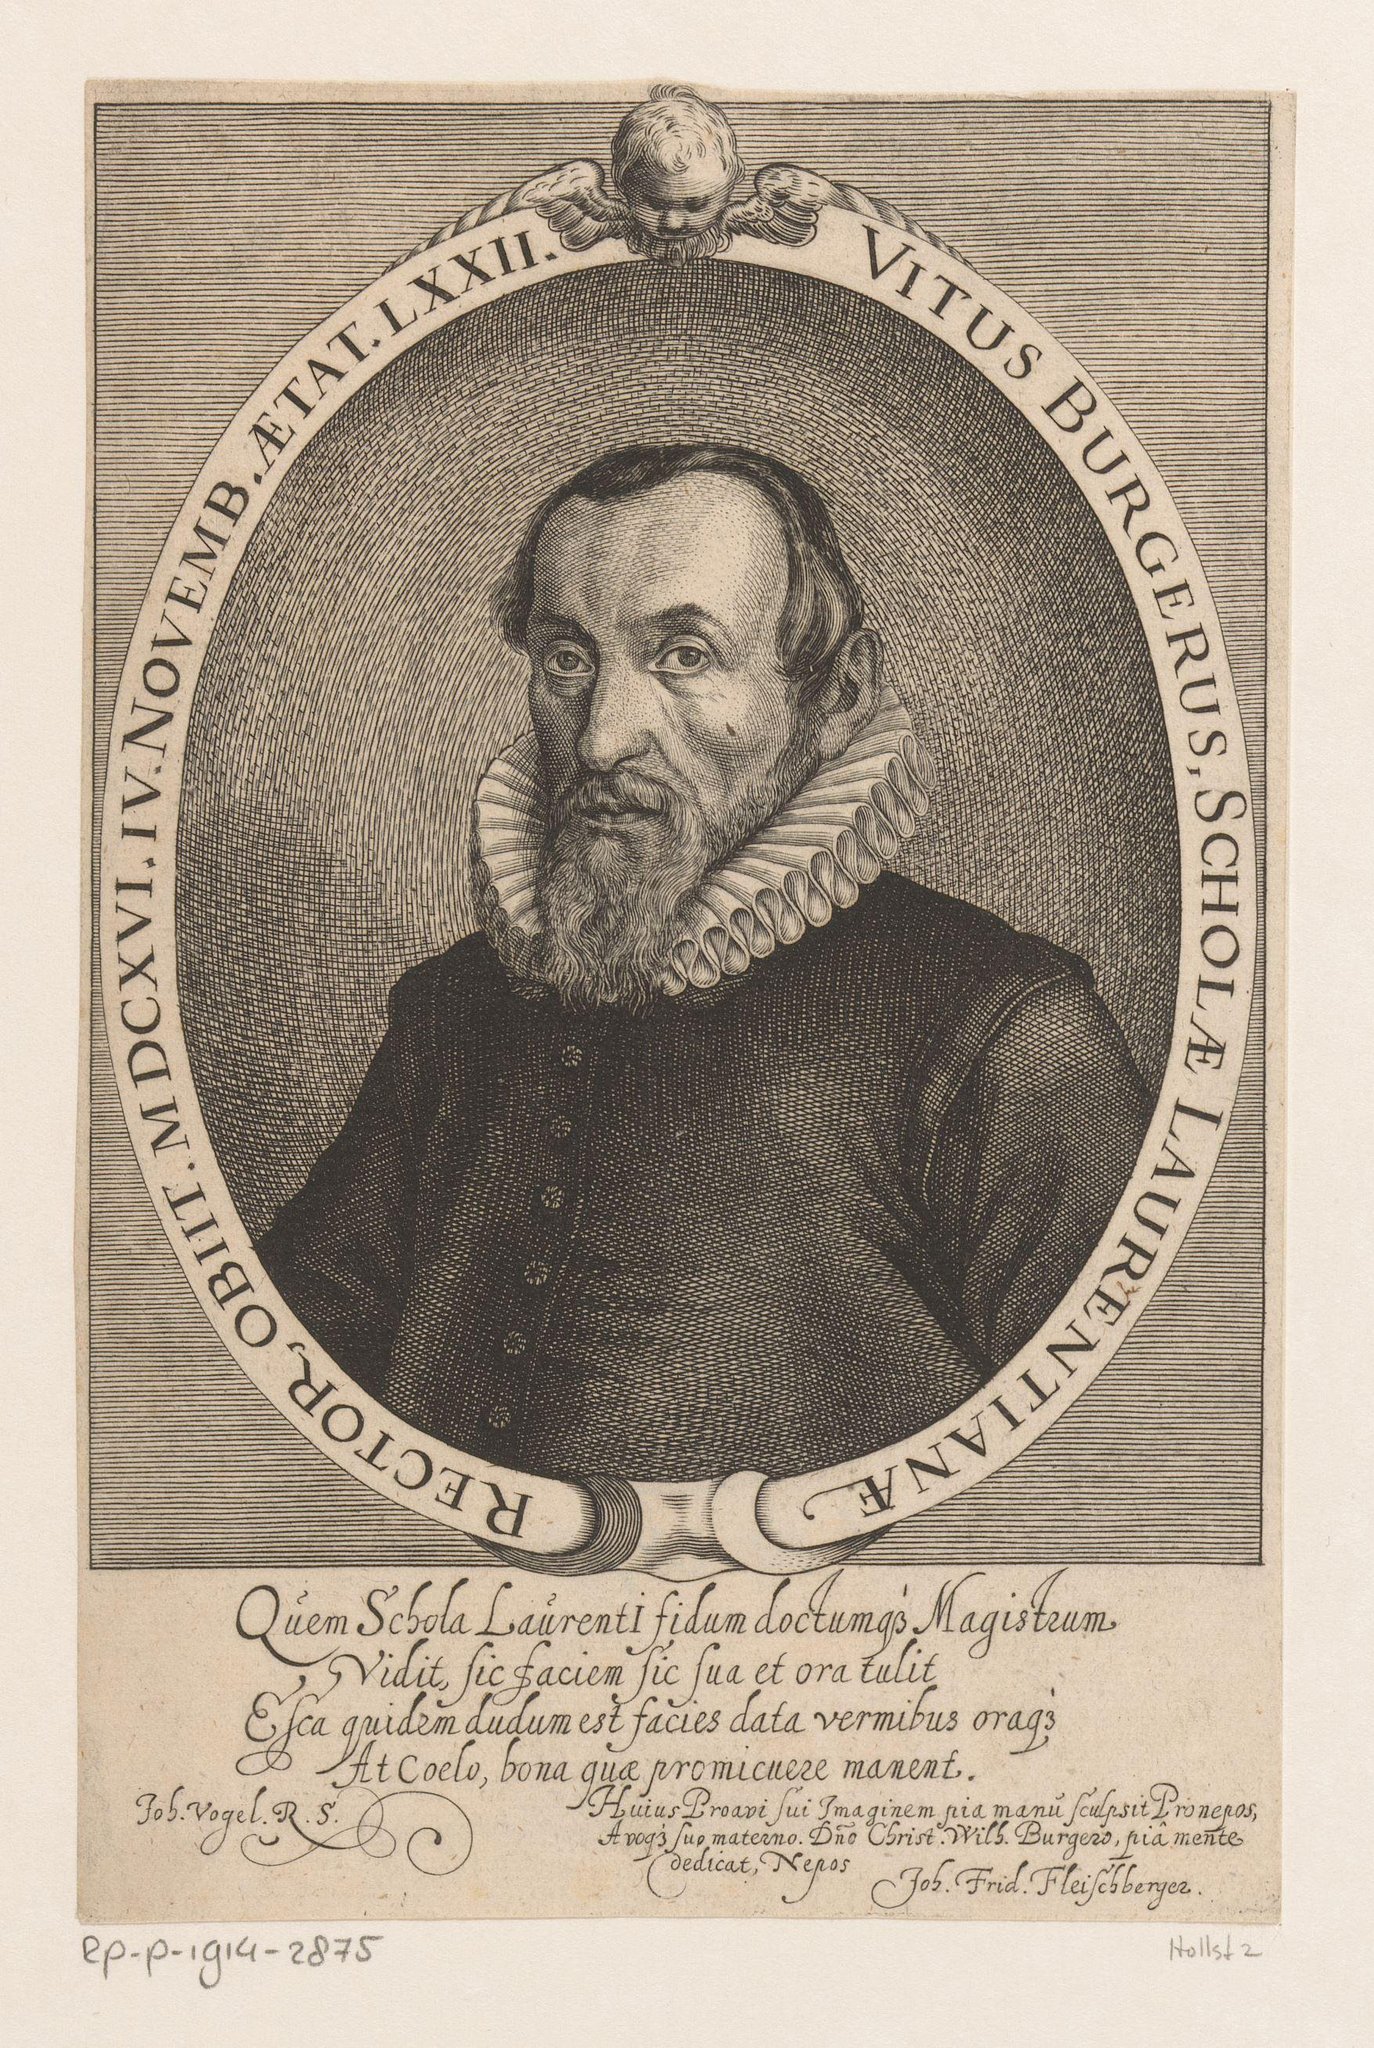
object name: print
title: Portret van Veit Burger op 72-jarige leeftijd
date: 1641-1665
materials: paper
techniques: engraving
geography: nuremberg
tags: cherubs, i.e. children's heads with wings, ornament ~ medallion, historical persons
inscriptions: collector's mark: Lugt 2228